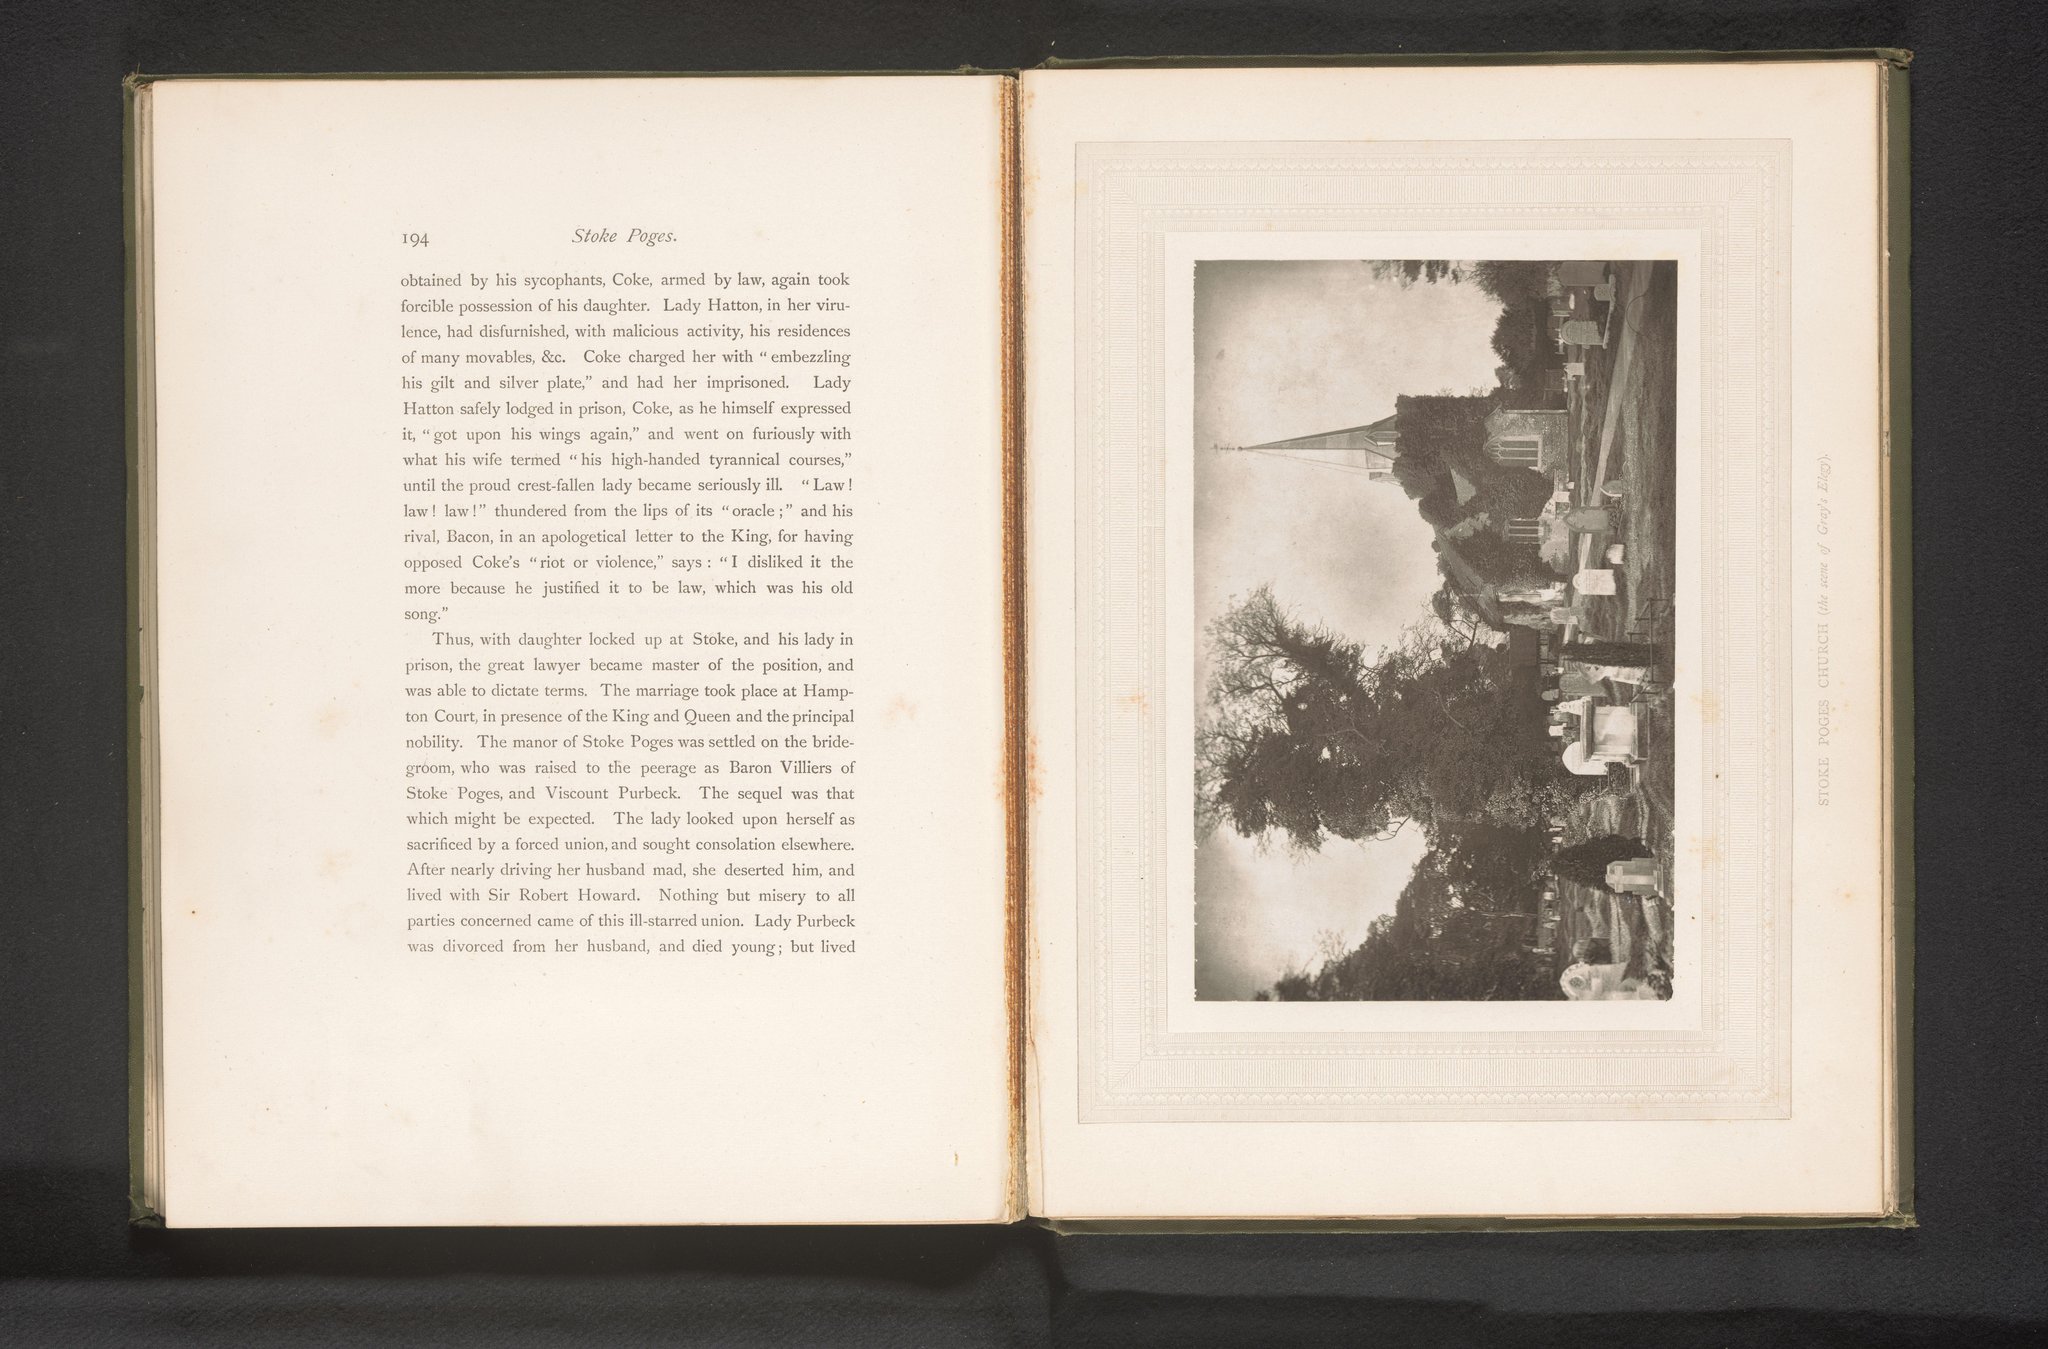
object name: photomechanical print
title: Gezicht op een kerk en een begraafplaats in Stoke Poges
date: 1866-1876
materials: paper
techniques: woodburytype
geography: stoke poges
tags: church (exterior), churchyard, cemetery